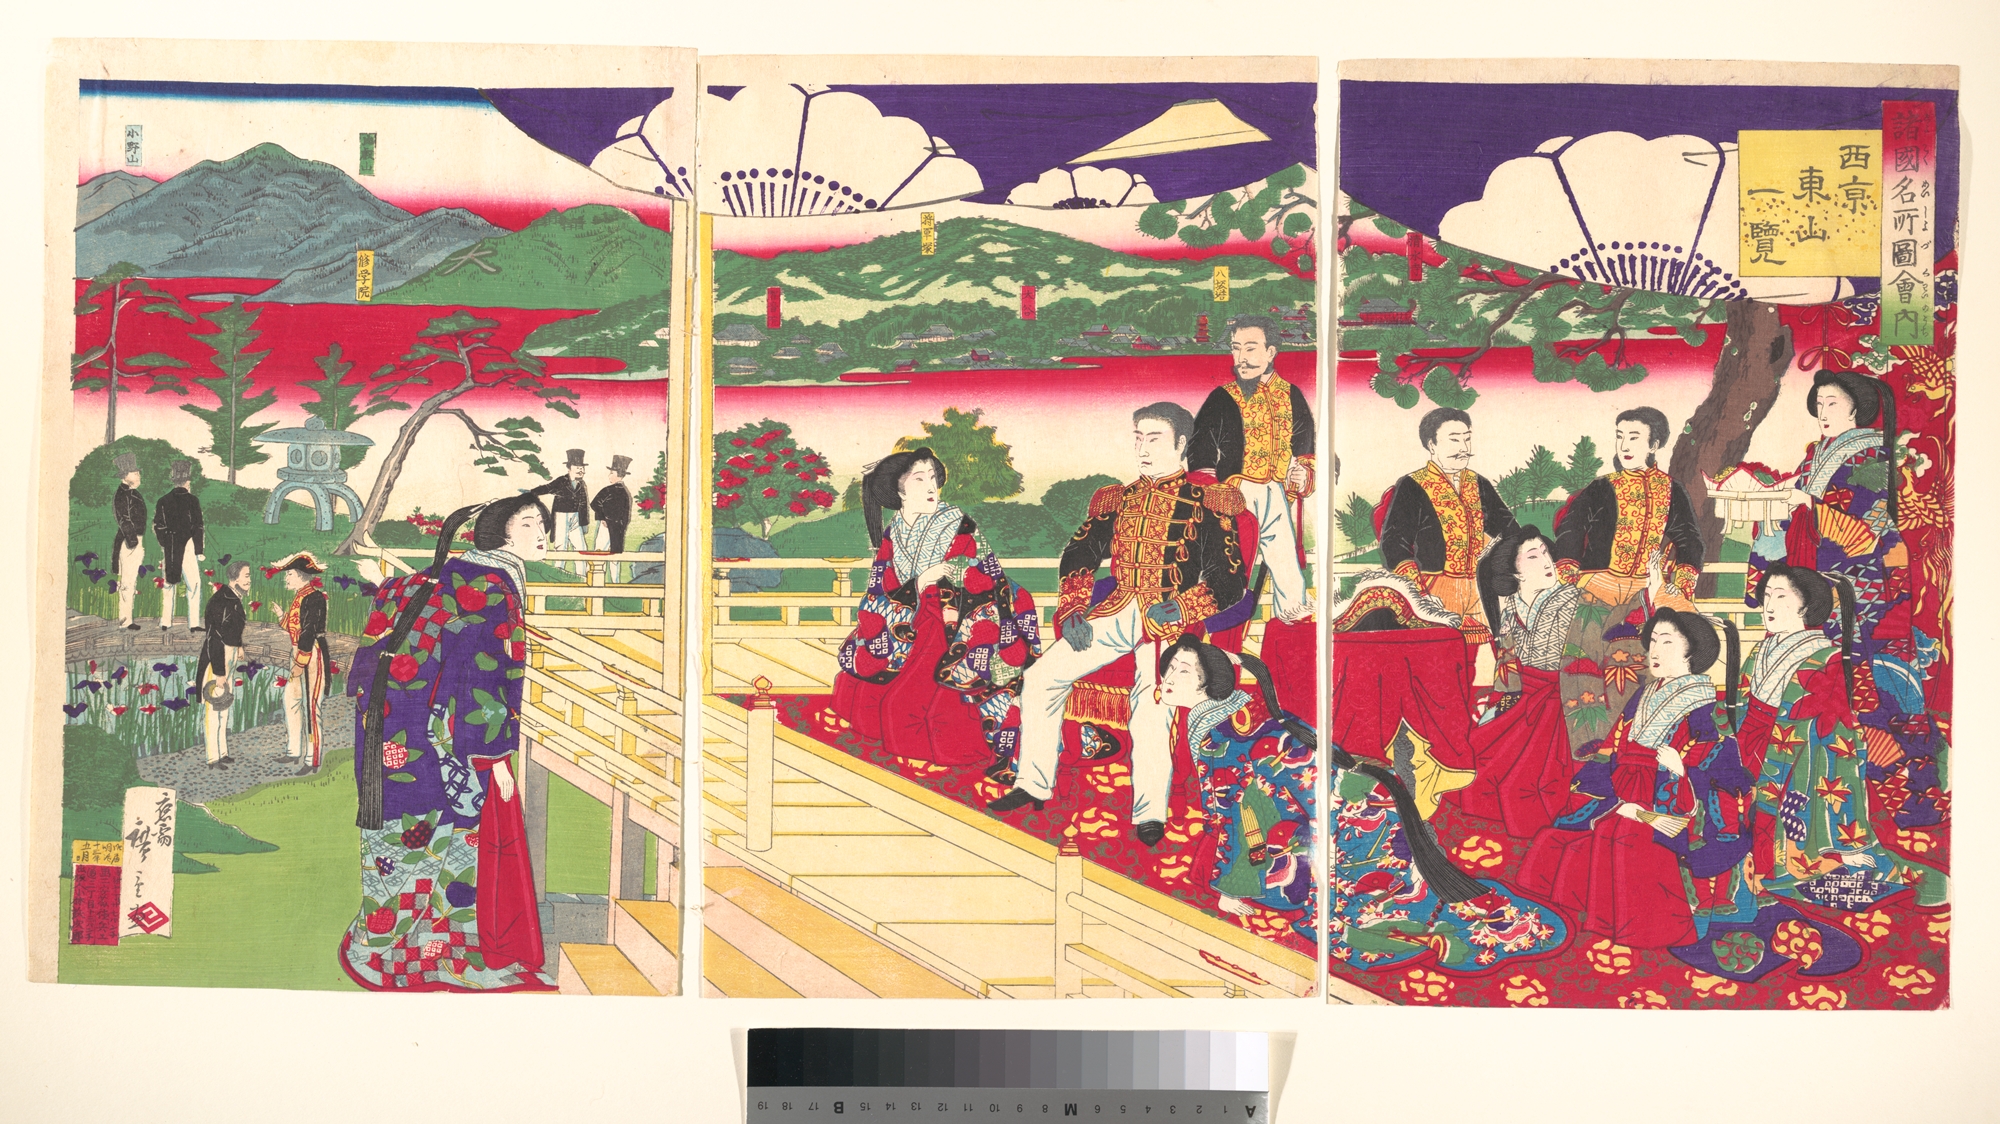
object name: woodblock print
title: A Glimpse of Higayashiyama the Western Capital, from the series Famous Places in the Nation (Shokoku meisho zukai no uchi-Saikyō Higashiyama ichiran)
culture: japanese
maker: utagawa hiroshige iii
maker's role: artist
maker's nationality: japanese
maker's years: 1843-1894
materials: ink, paper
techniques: woodblock print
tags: men,women,flowers,hills